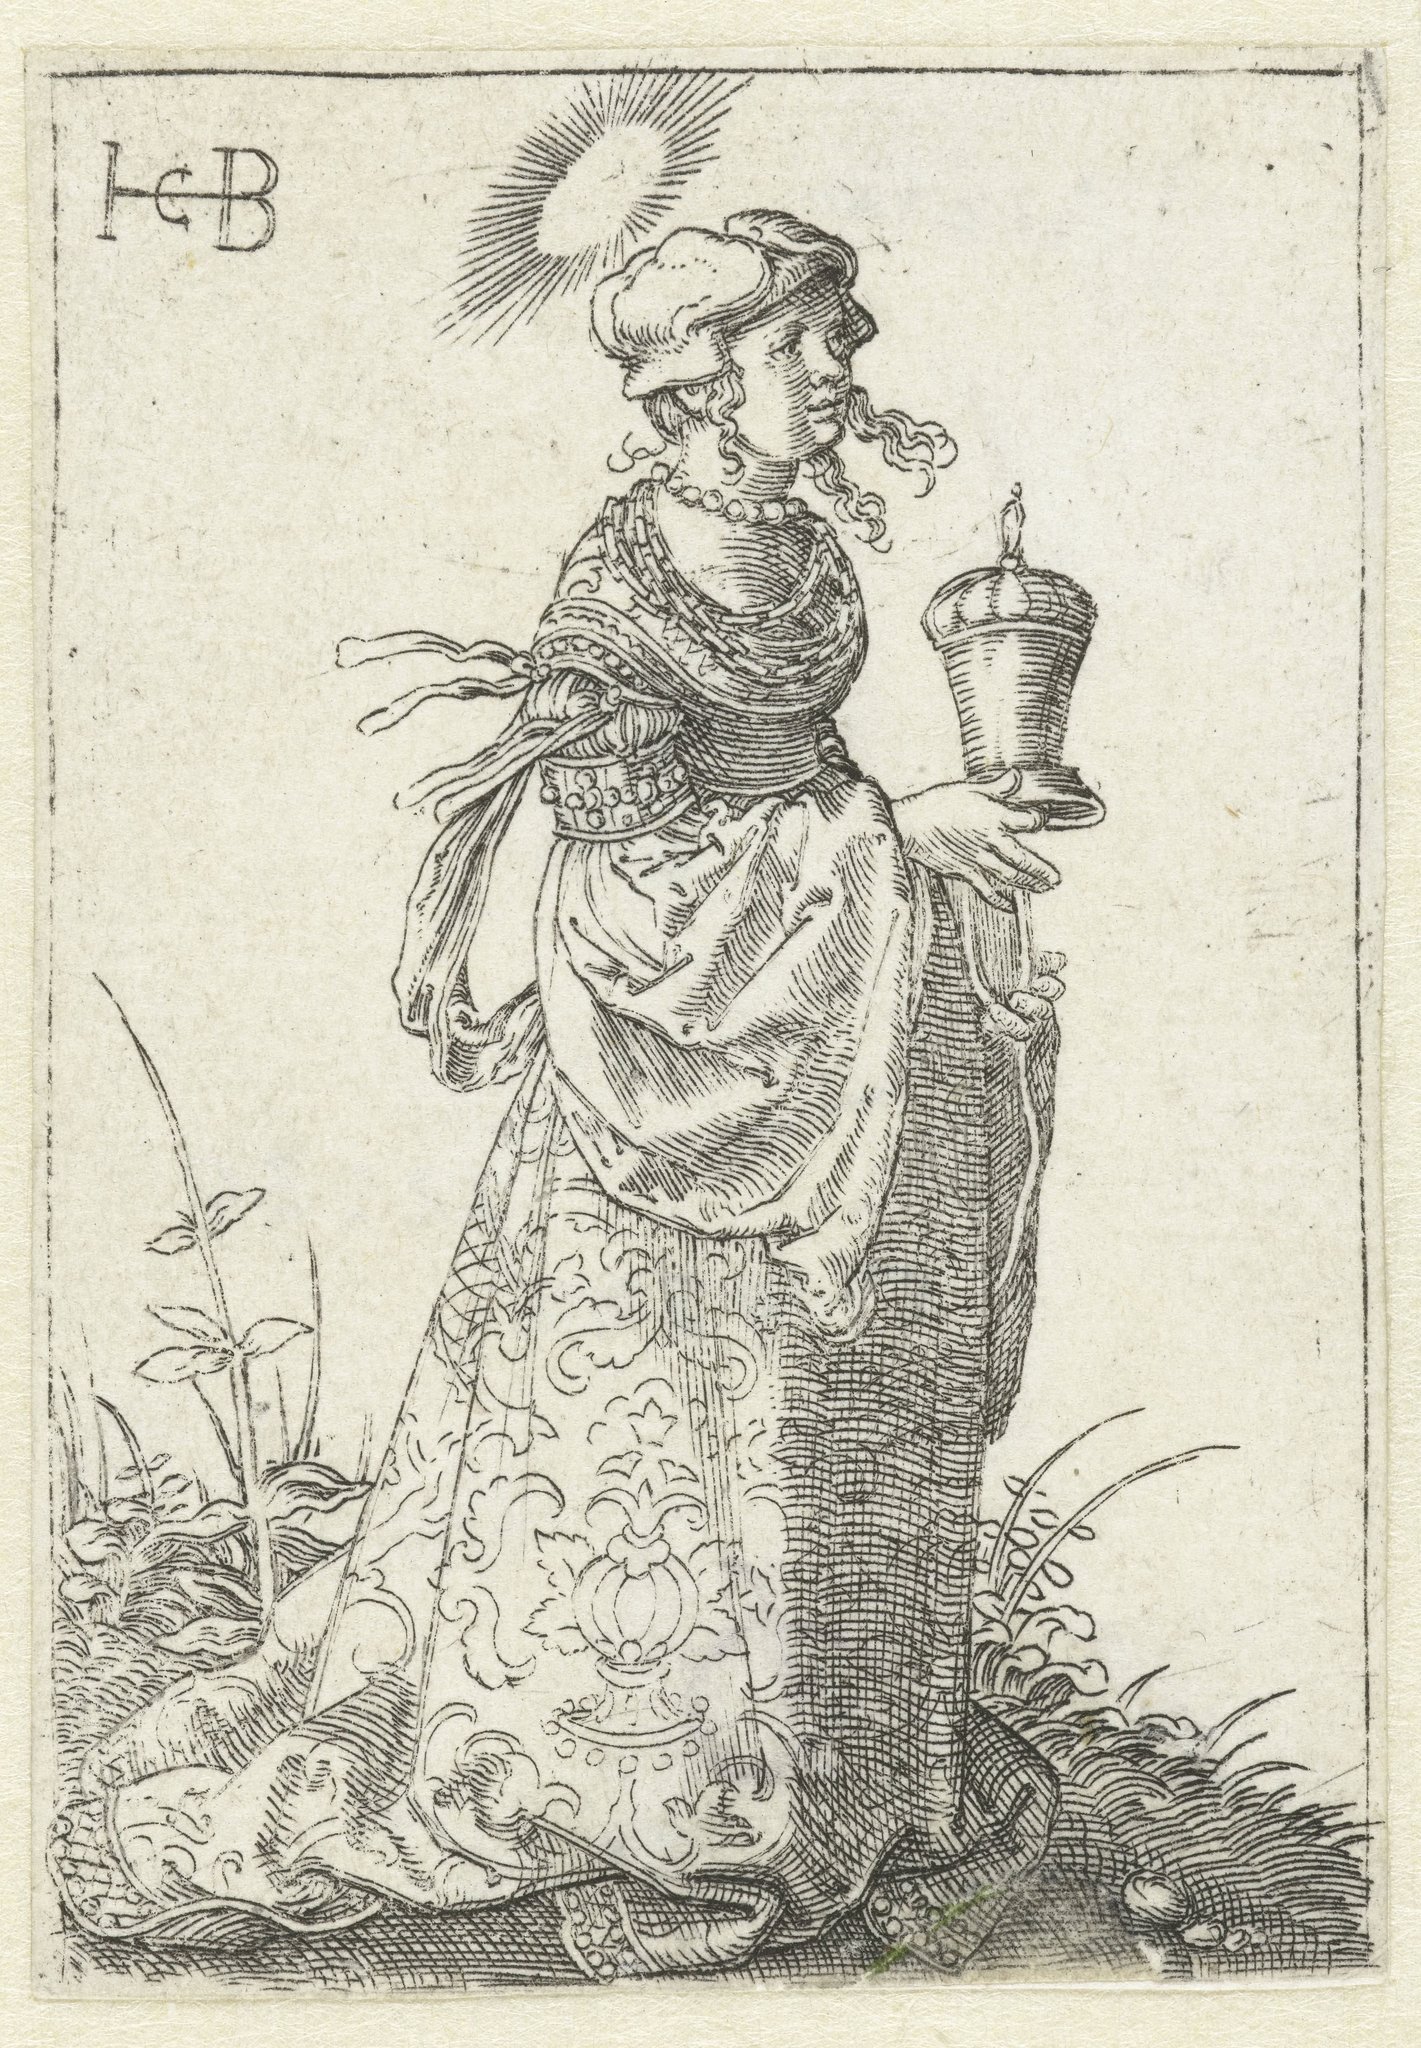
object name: print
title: Maria Magdalena met zalfpot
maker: jacob binck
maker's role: painter, print maker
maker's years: 1494-1569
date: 1526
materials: paper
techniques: engraving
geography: germany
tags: the penitent harlot mary magdalene; possible attributes: book (or scroll), crown, crown of thorns, crucifix, jar of ointment, mirror, musical instrument, palm-branch, rosary, scourge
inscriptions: collector's mark: ‘D of DL’, collector's mark: Lugt 2760, collector's mark: Lugt 2228 a